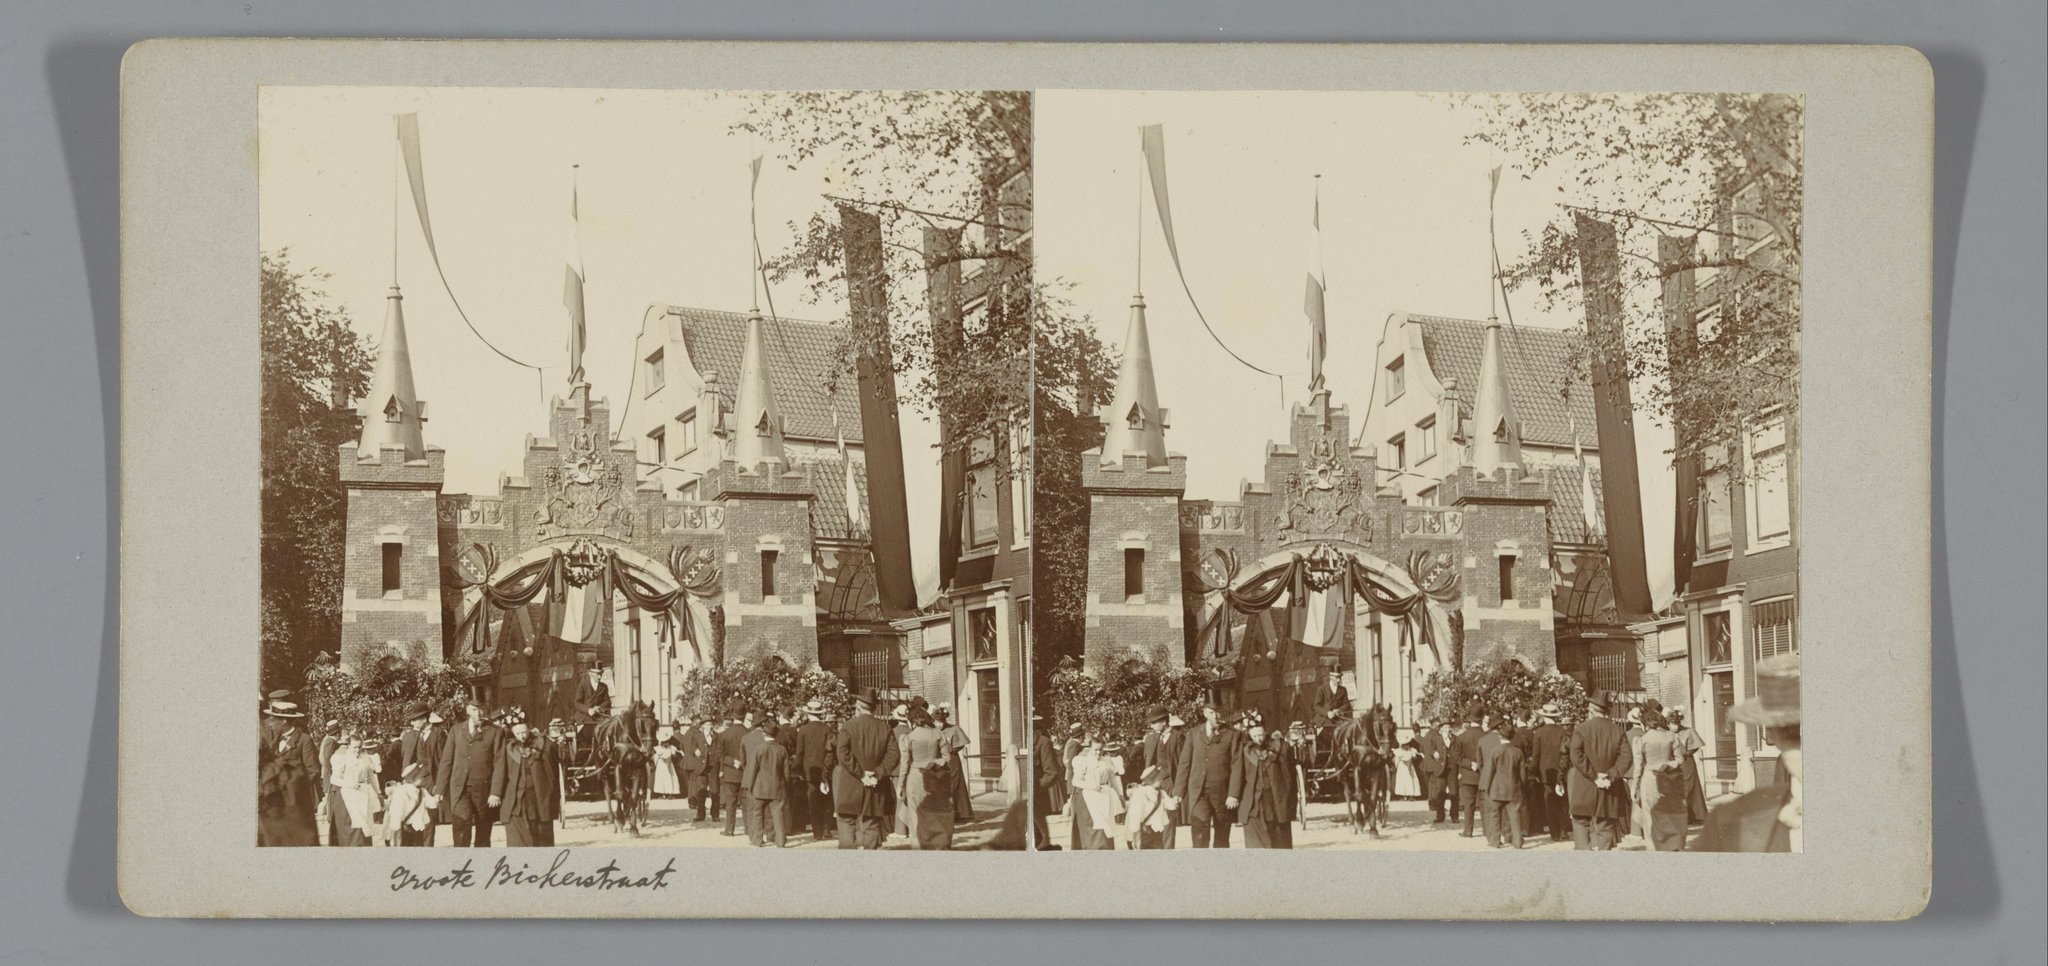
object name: stereograph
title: Groote Bickerstraat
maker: Anonymous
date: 1898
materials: paper, cardboard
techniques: gelatin silver print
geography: amsterdam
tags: the hague, print maker, wilhelmina of the netherlands, gate, entrance, amsterdam